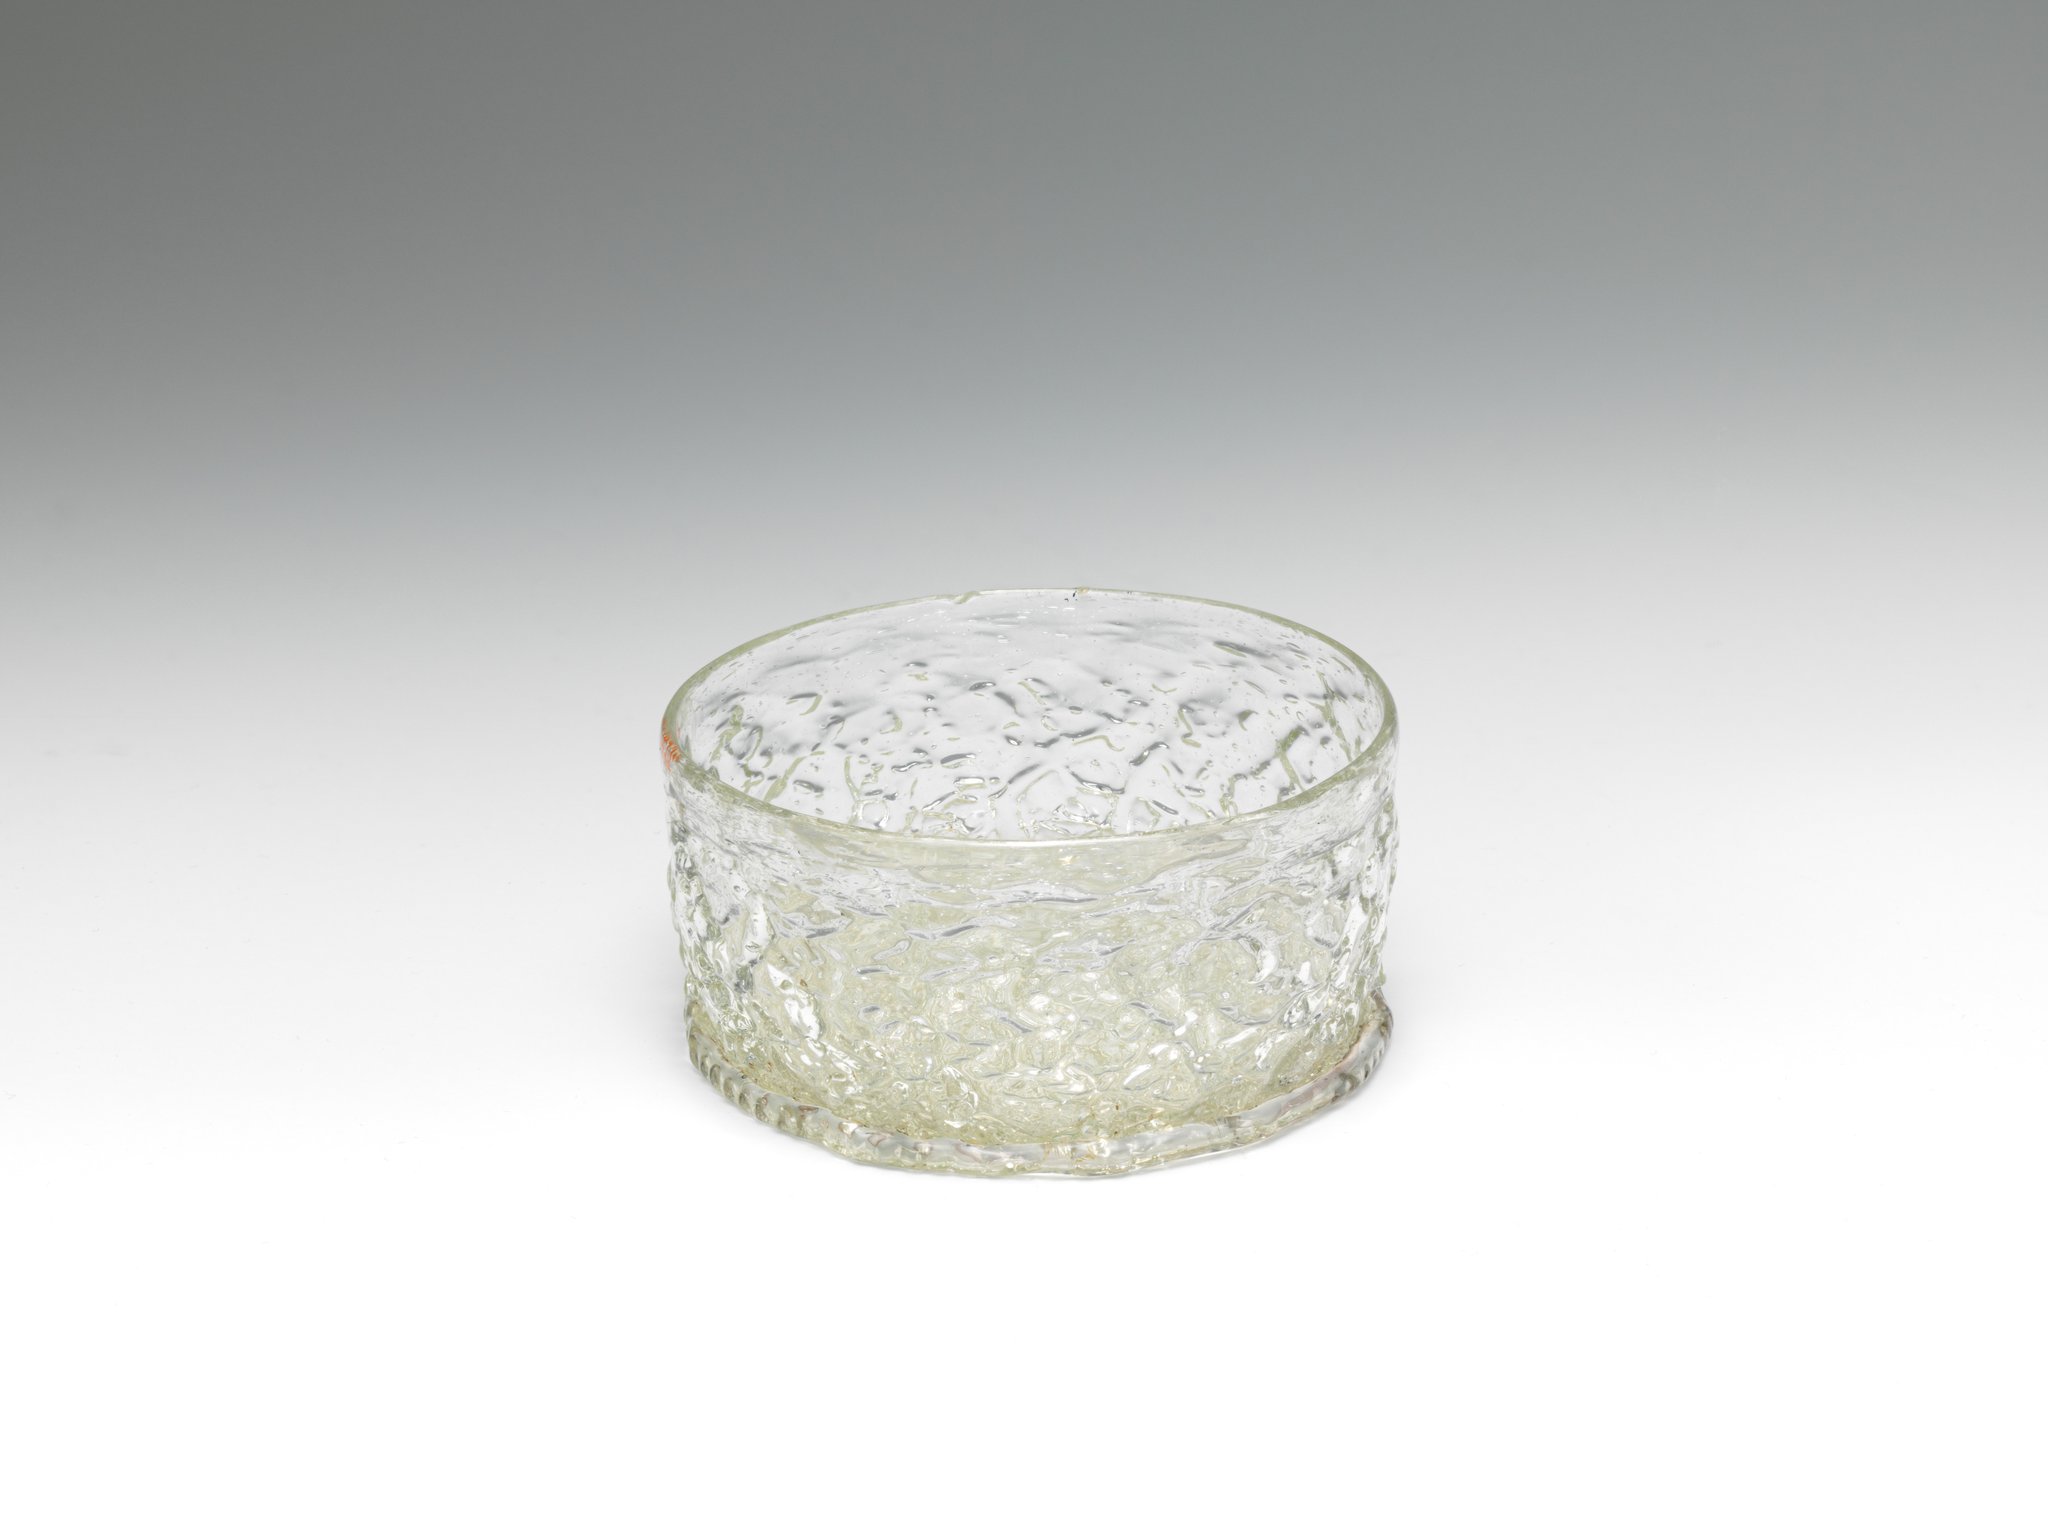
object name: saltcellar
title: Saltcellar (?)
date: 1701-1900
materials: glass